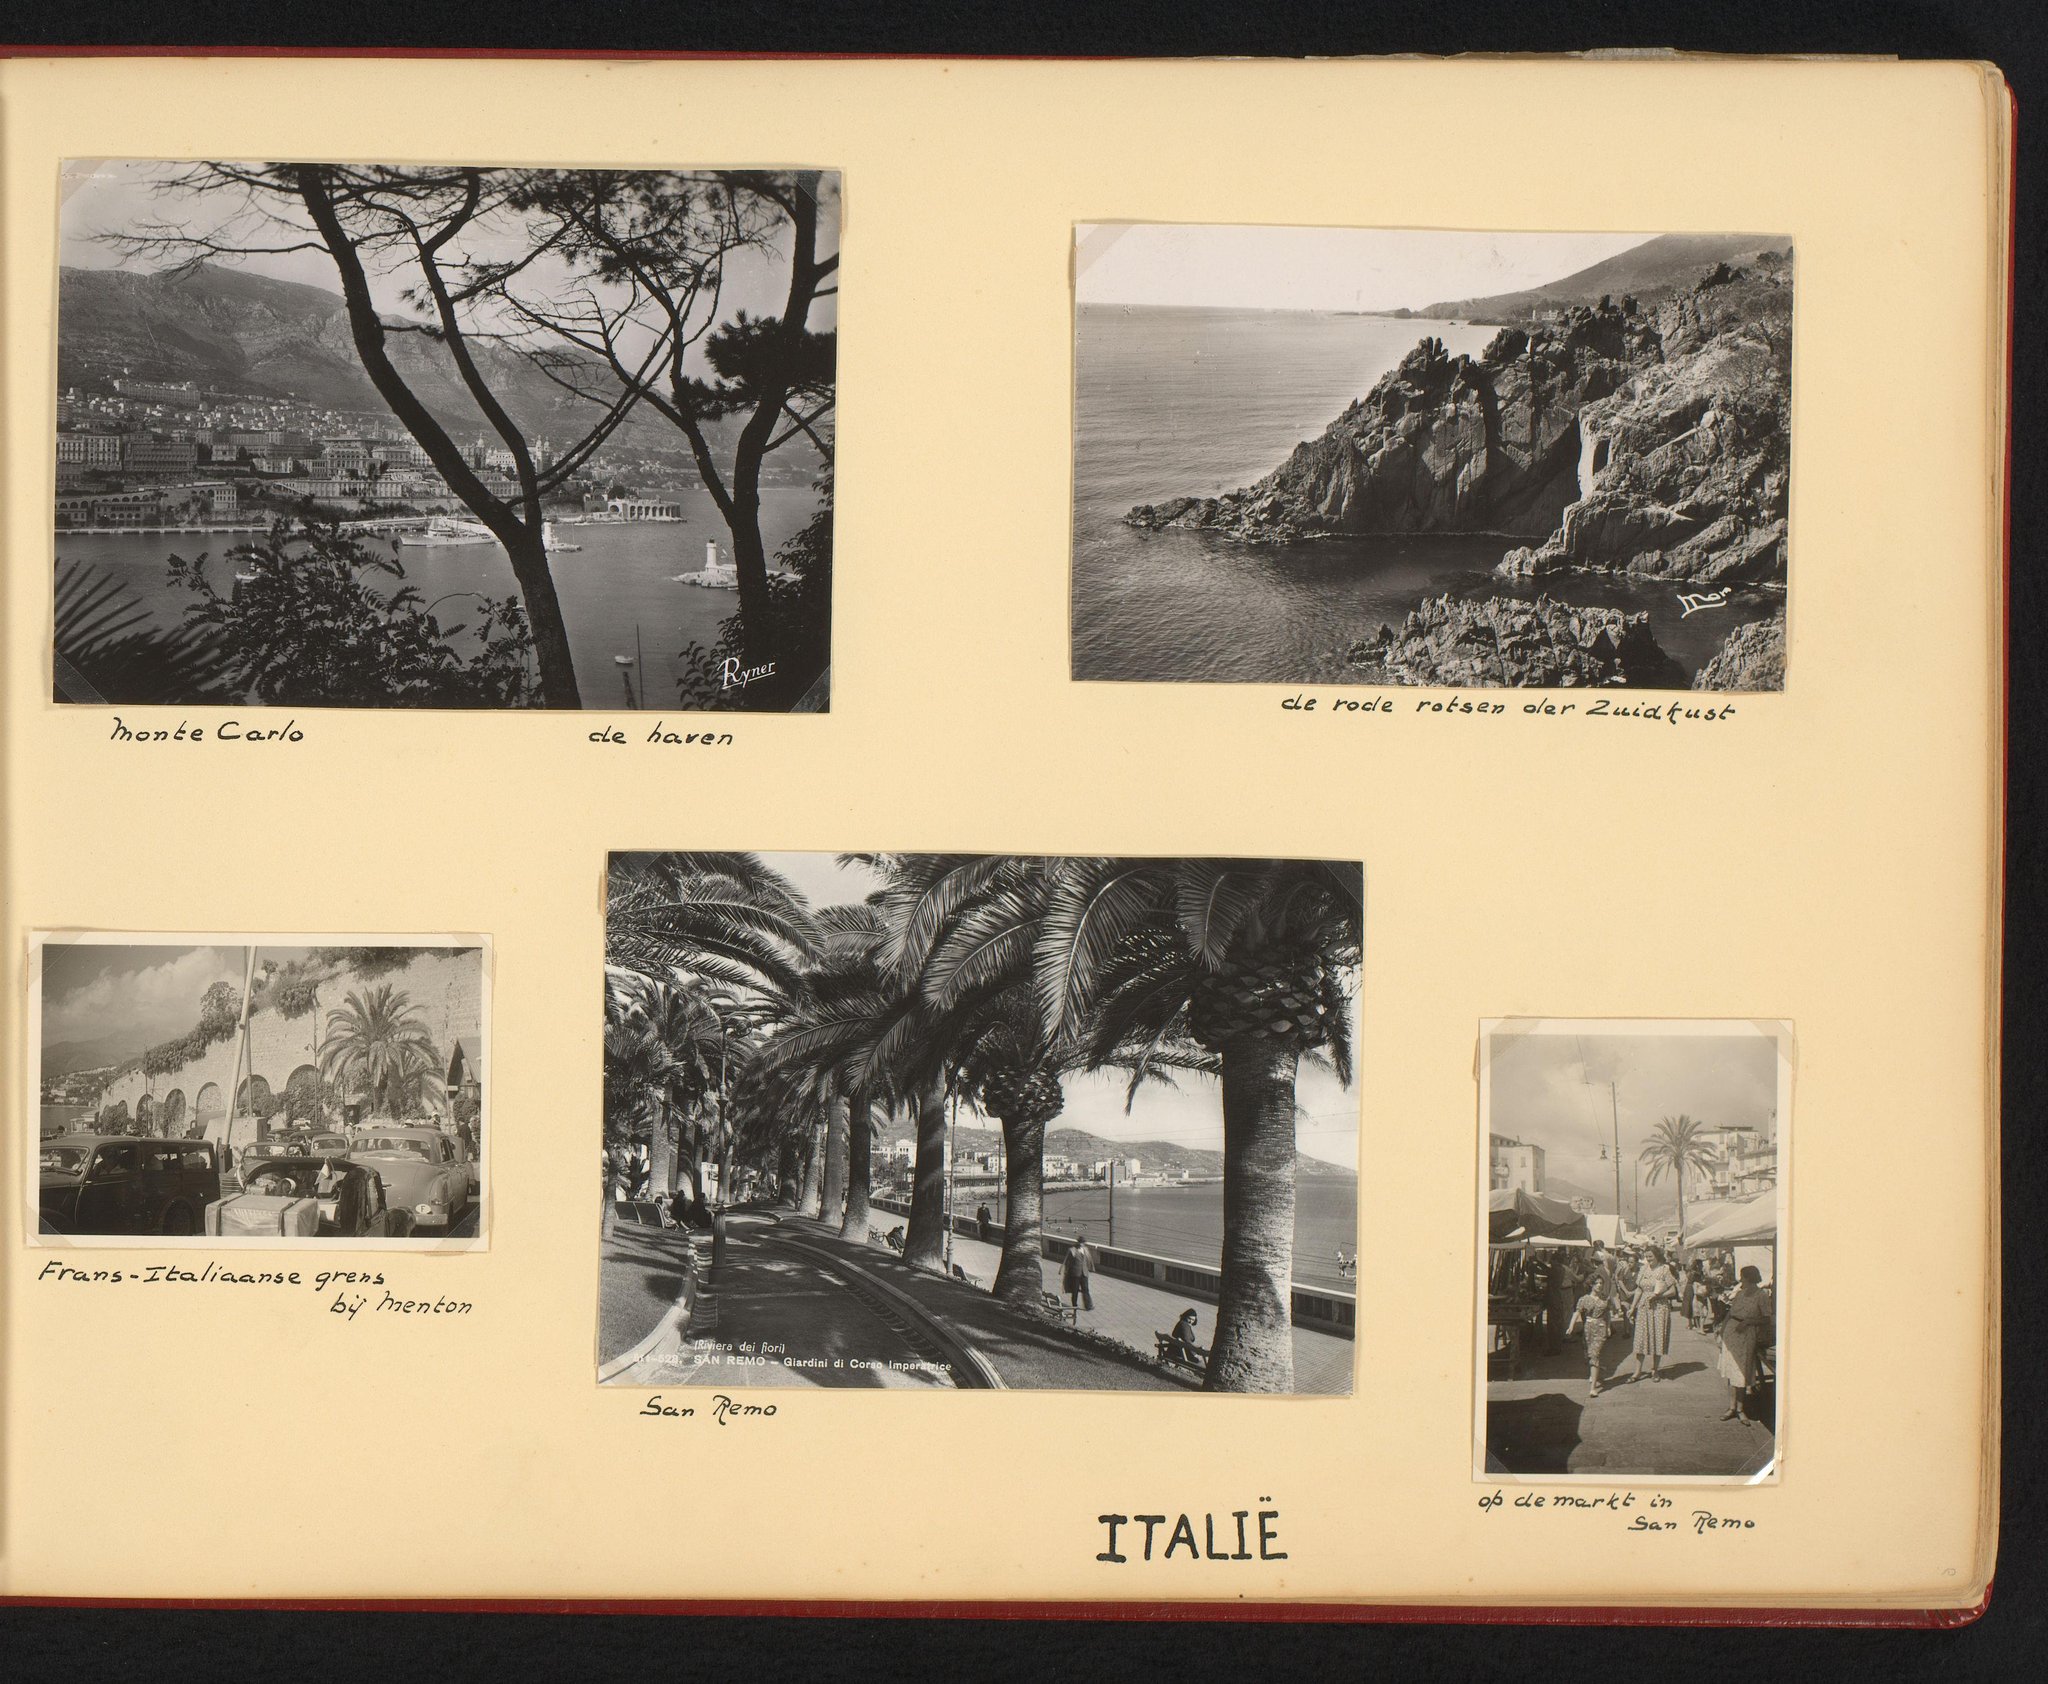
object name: photograph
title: Italië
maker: Anonymous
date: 1951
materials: paper, photographic support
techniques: gelatin silver print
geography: italy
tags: the family travelling, on holiday, rocky coast, outing, pleasure trip, avenue, boulevard, promenade, esplanade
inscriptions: inscription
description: Albumblad met twee prentbriefkaarten en drie foto's van de Franse kust en San Remo. Herinnering aan een vakantiereis door Frankrijk van 23 augustus tot 9 september 1951. Onderdeel van het fotoalbum 'Met de Fiat 500 cabriolet op vakantie' met foto's van vakanties van een gezin tussen 1951-1959.